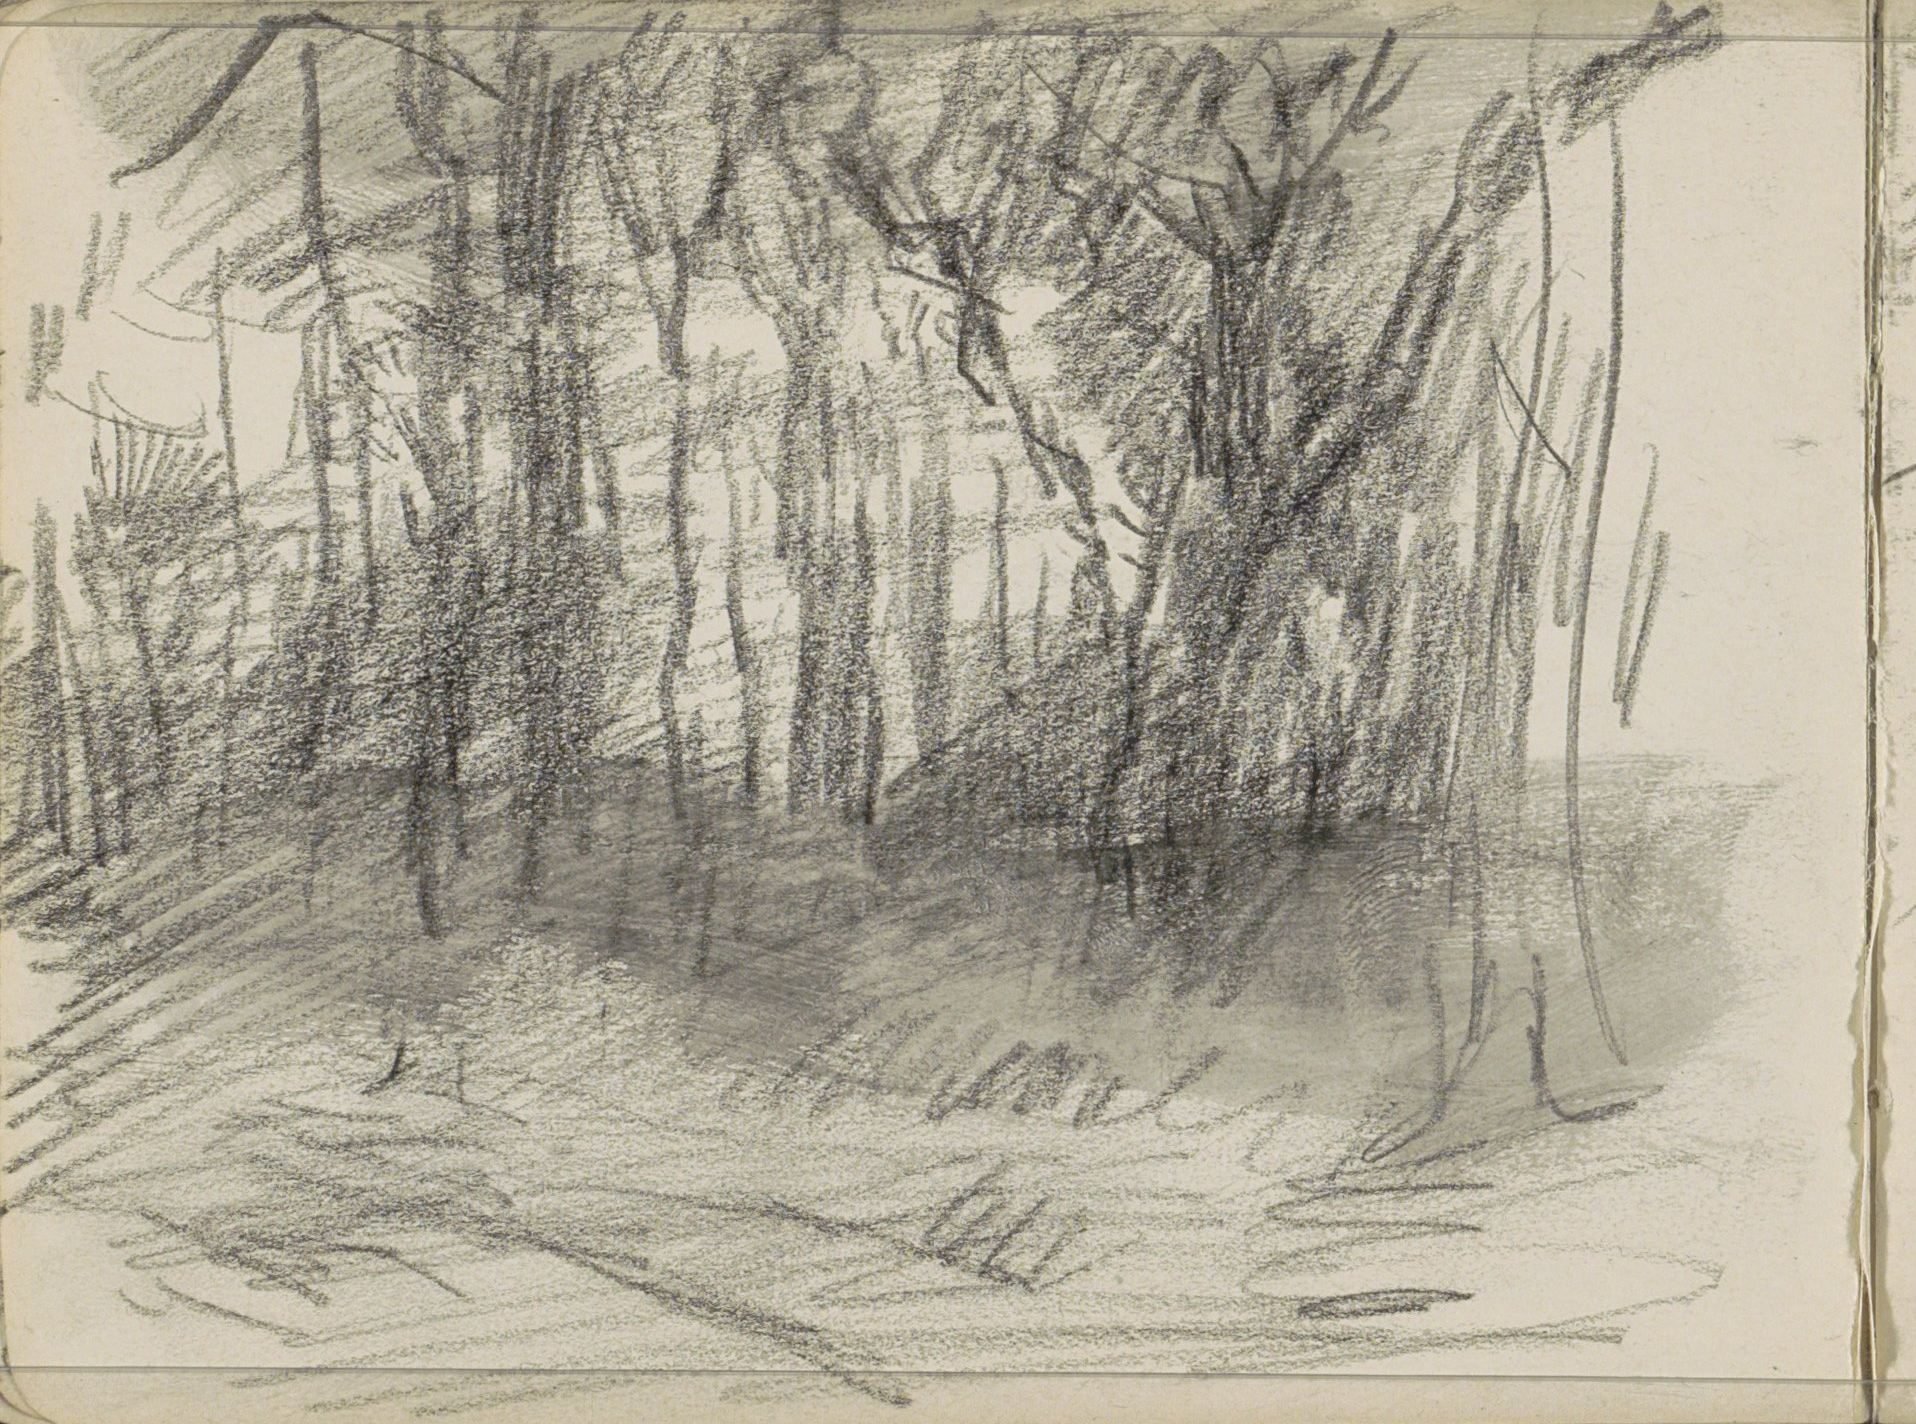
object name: sketchbook leaf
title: Landschap met bomen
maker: johan antonie de jonge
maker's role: draughtsman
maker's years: 1864-1927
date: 1884-1927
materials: chalk, paper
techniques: stumping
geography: south holland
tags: trees, landscapes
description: Landschap met bomen. Blad 26 verso uit een schetsboek met 33 bladen.